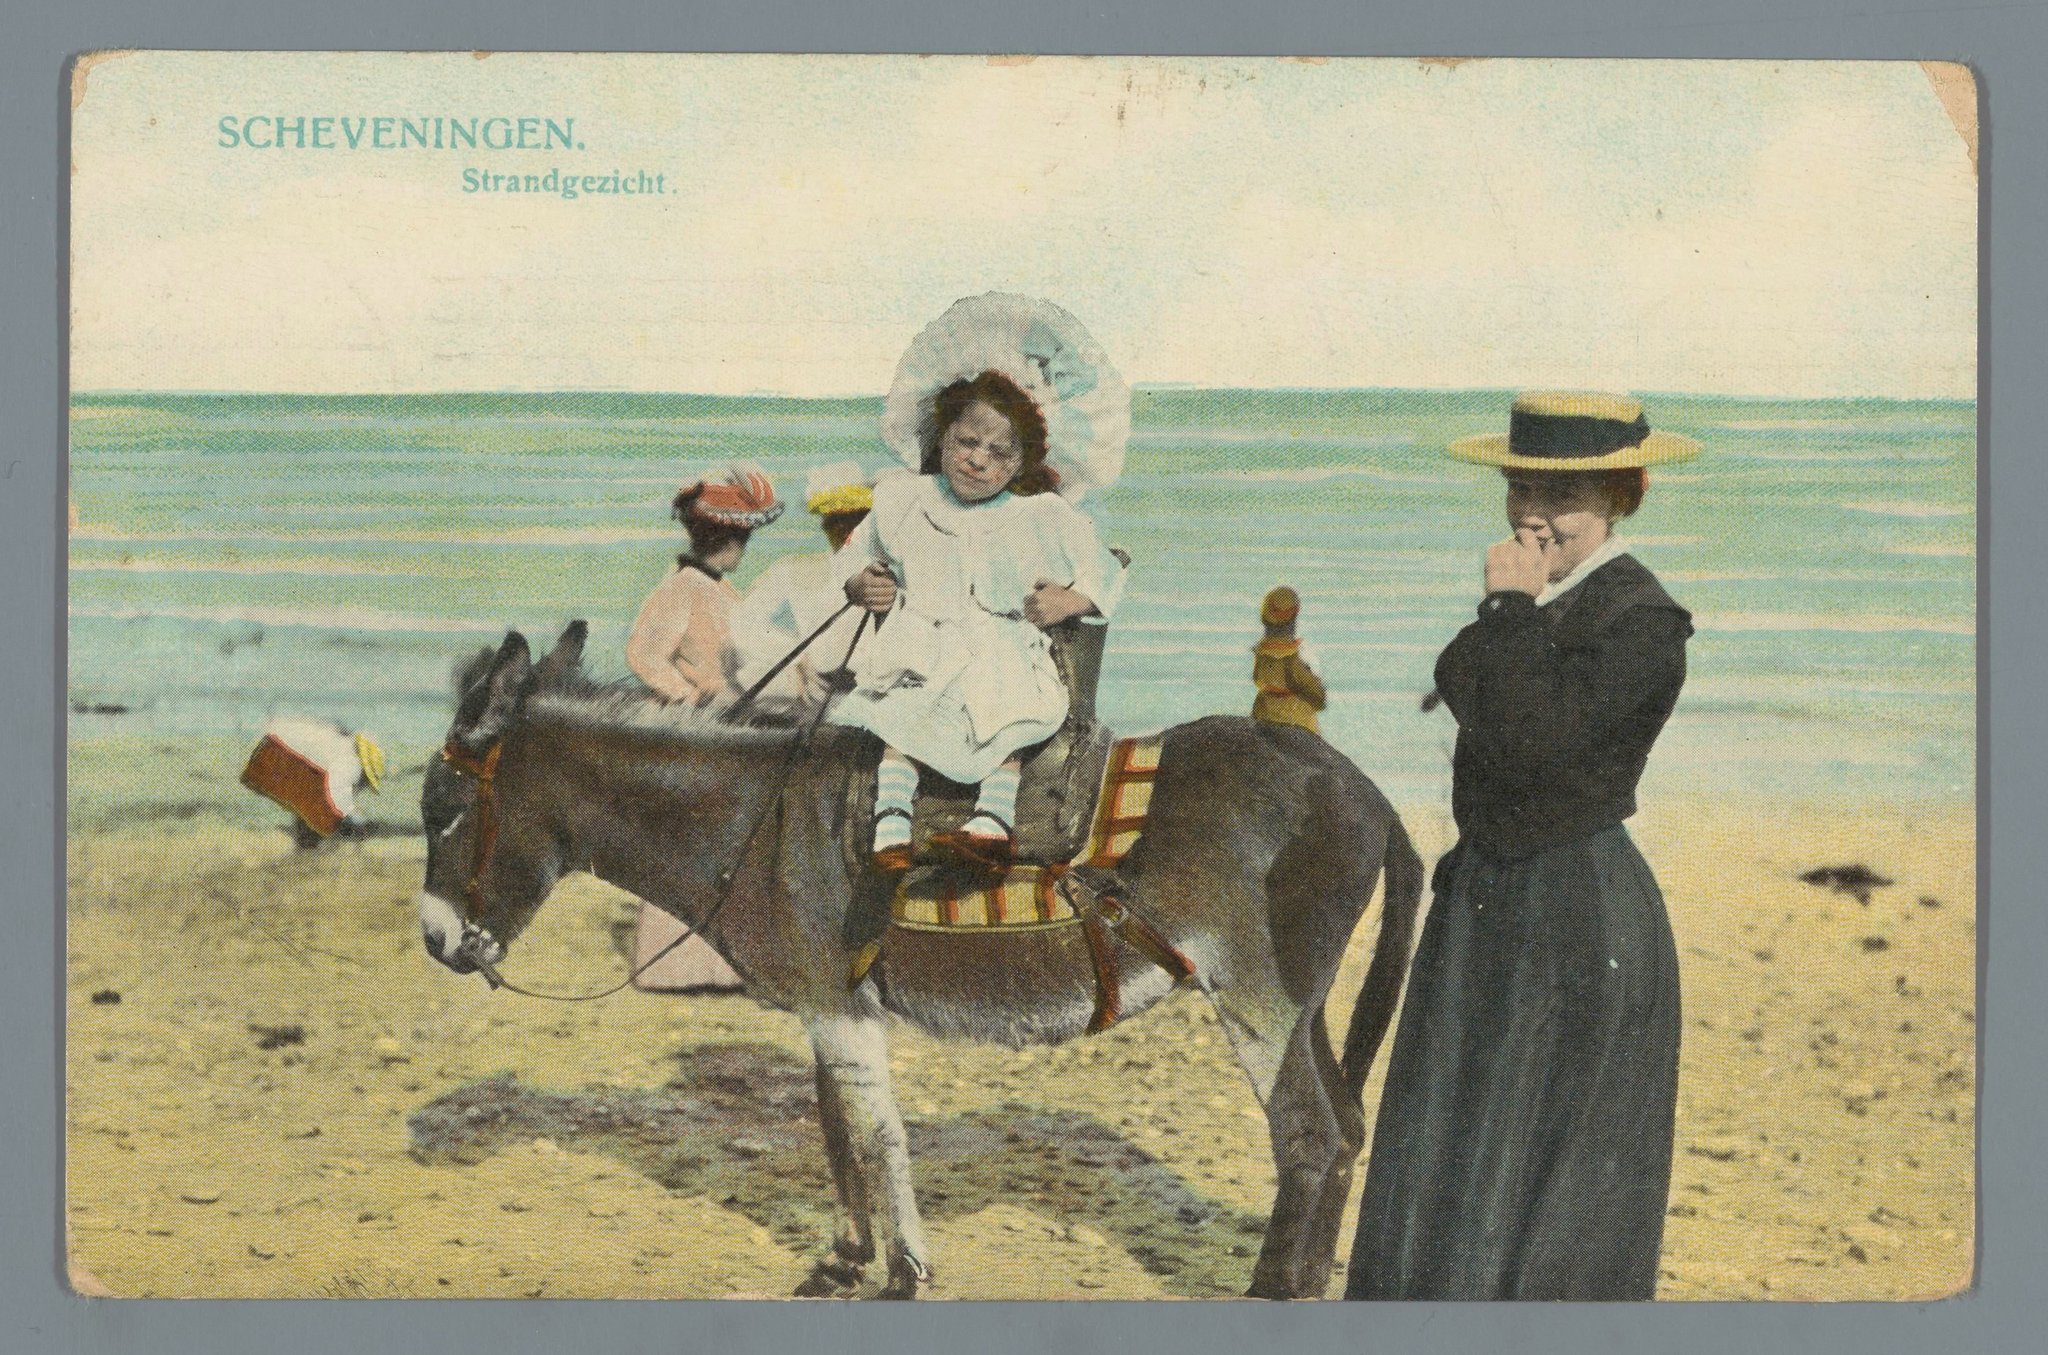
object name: photomechanical print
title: Scheveningen, Strandgezicht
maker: Anonymous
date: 1909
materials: cardboard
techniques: writing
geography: scheveningen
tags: child, beach, donkey-riding (on the beach)